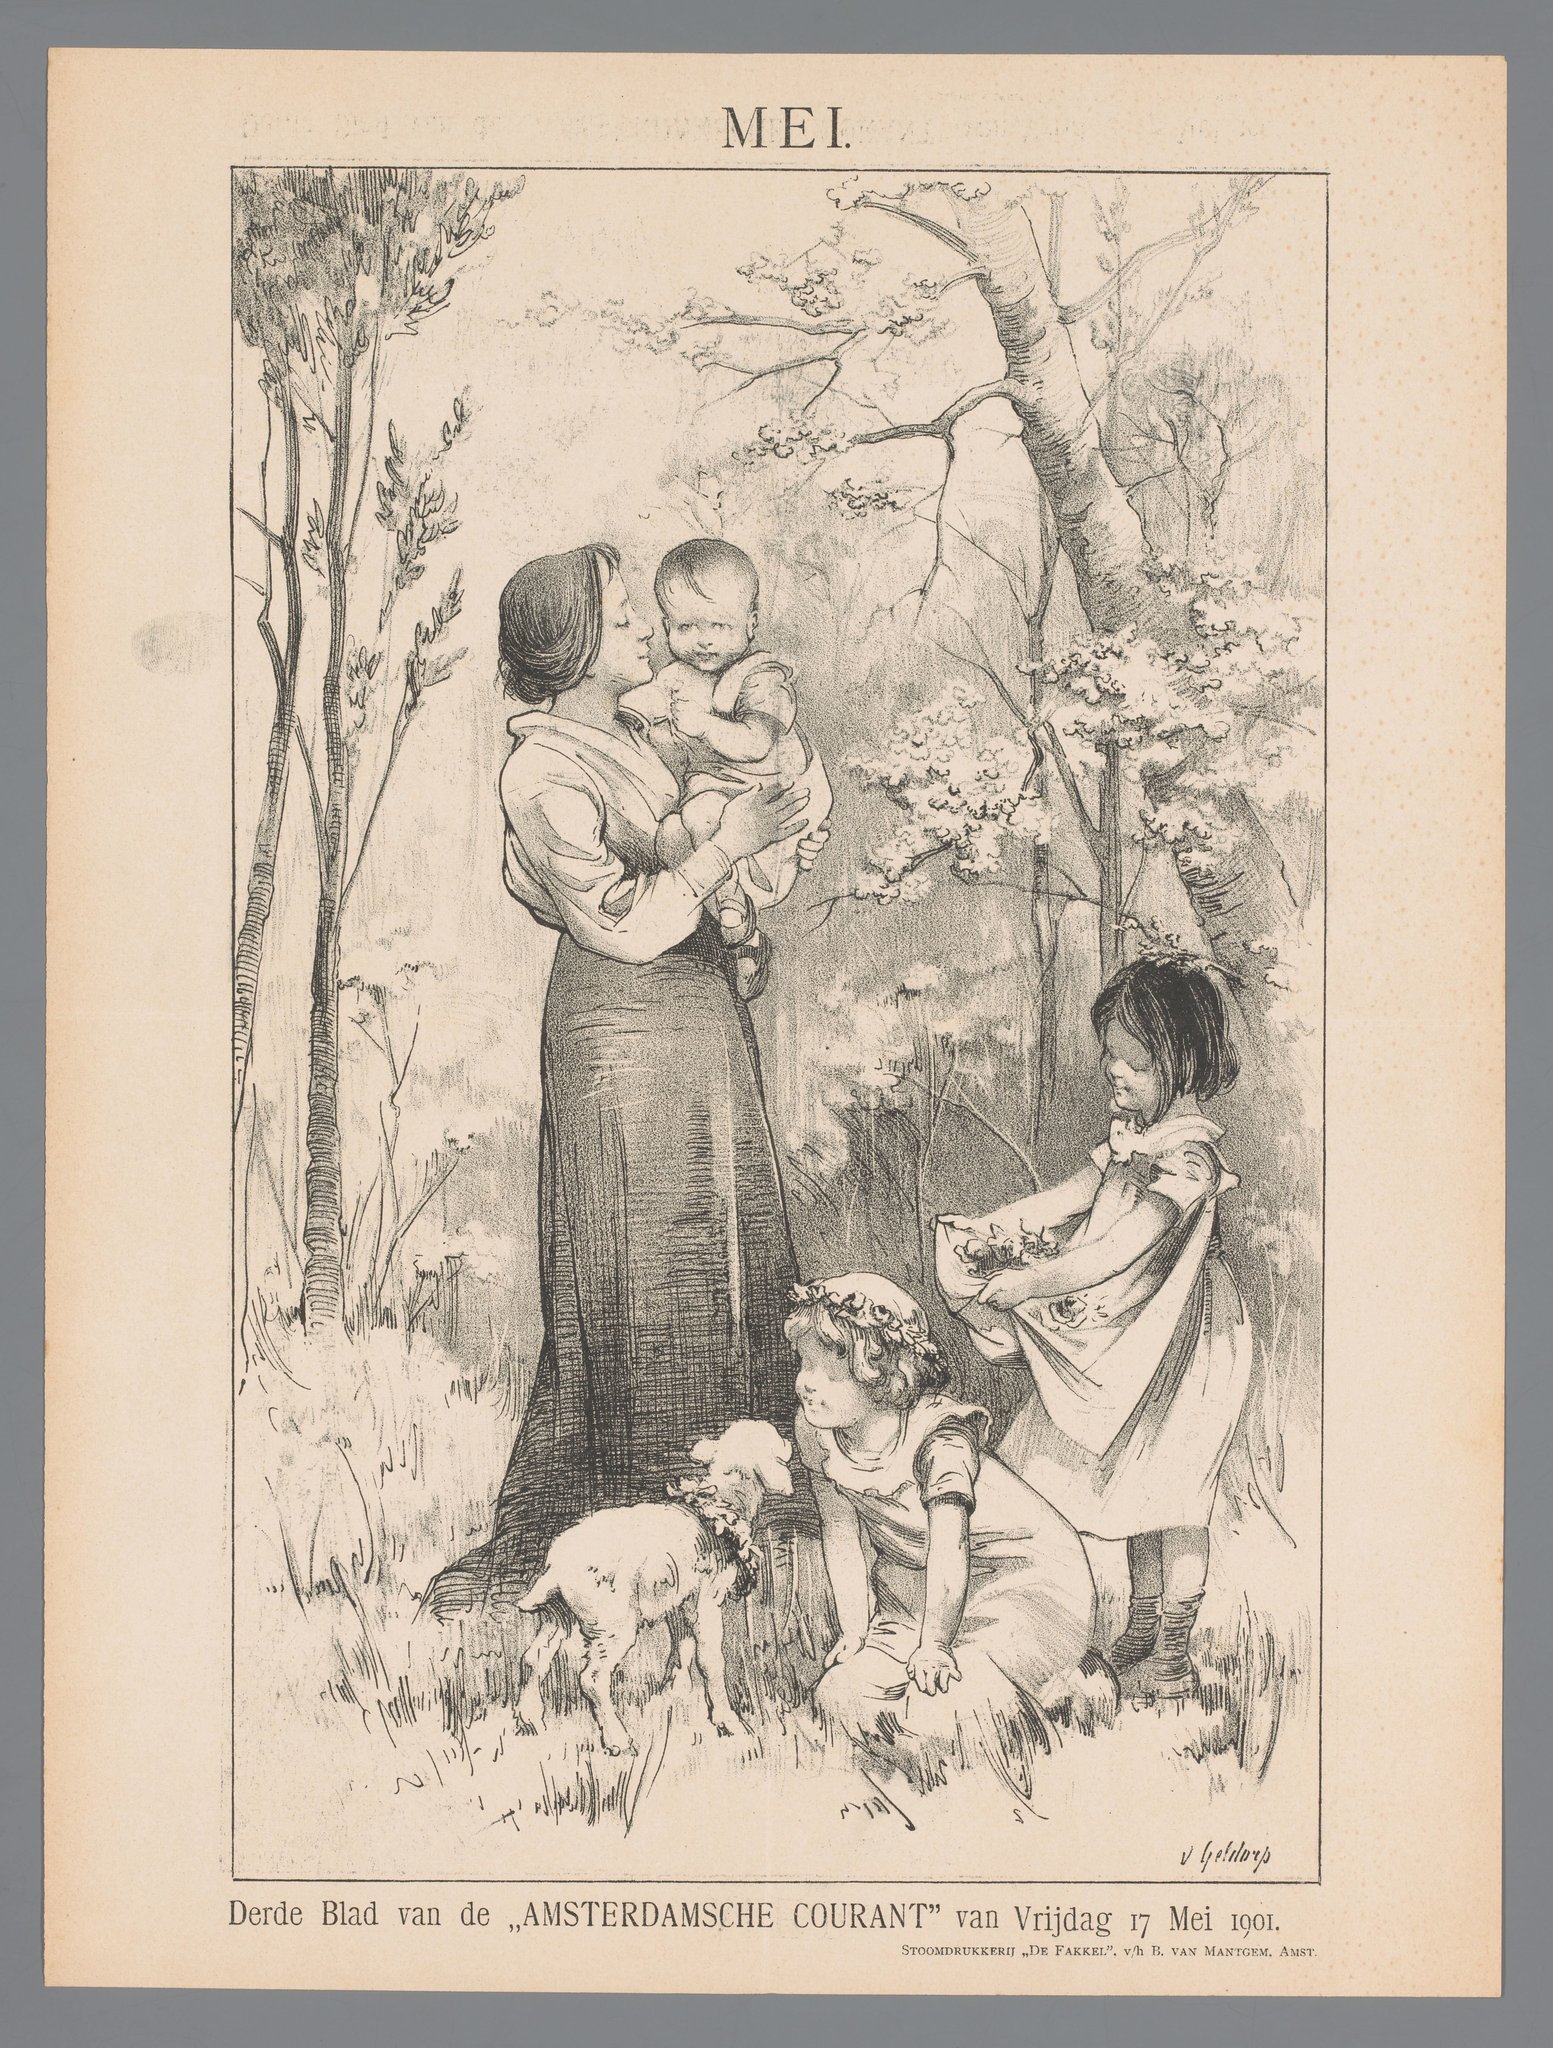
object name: print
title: Mei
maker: petrus van geldorp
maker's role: draughtsman, print maker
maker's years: 1872-1939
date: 1901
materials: paper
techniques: lithograph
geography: amsterdam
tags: landscape symbolizing may, mother and baby or young child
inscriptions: date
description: Prent uit het bijvoegsel van: De Amsterdamsche Courant, 17 mei 1901.